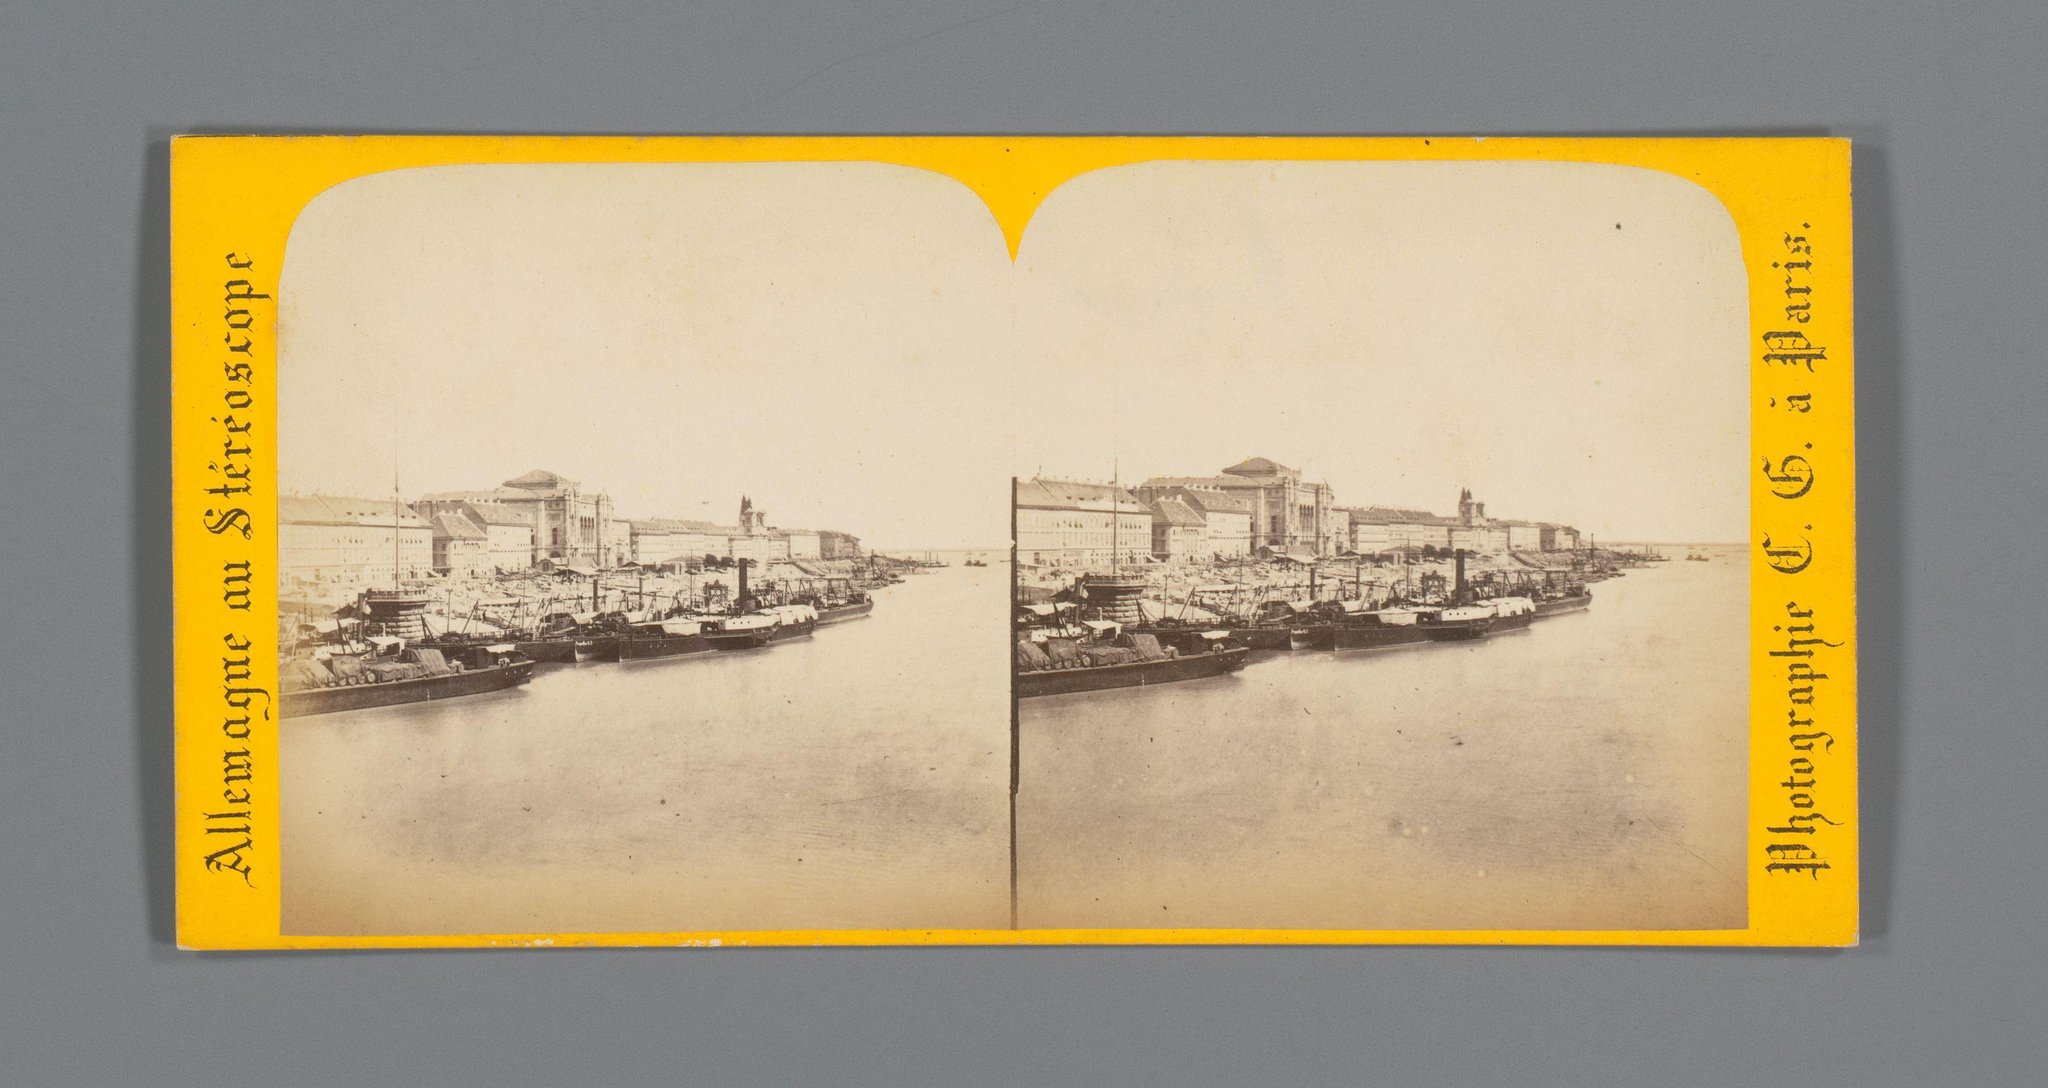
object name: stereograph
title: Gezicht op een haven en een kade in Pest, Boedapest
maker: charles gaudin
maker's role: publisher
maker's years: 1825-1905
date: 1868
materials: cardboard, paper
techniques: albumen print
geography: budapest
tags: harbour, ships (in general) - cc - more than one ship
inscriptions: number: ‘120.’, inscription: ‘120’